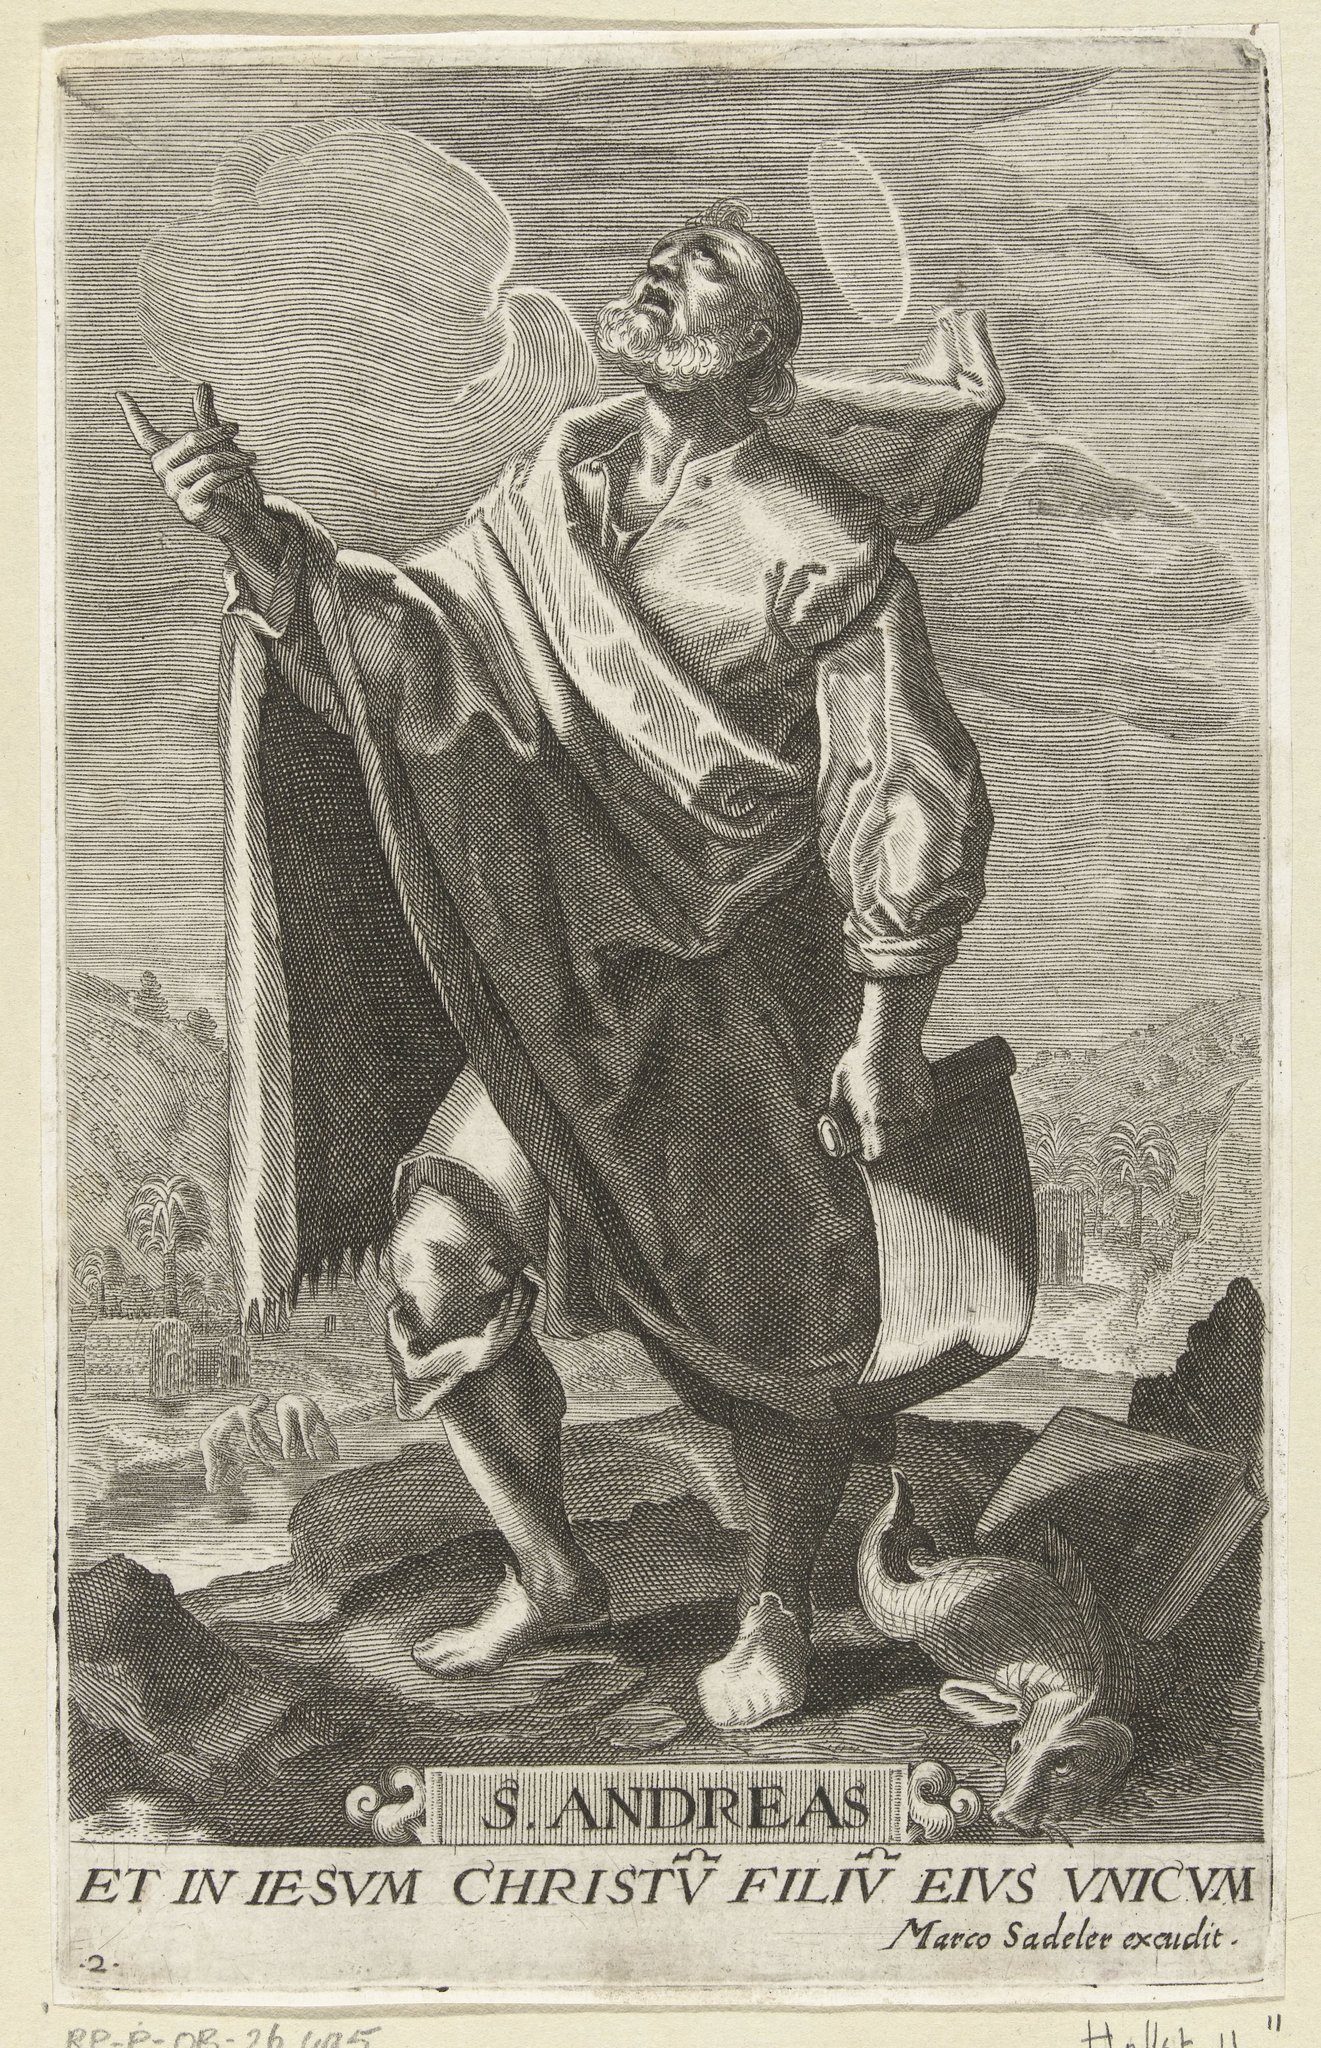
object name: print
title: Christus en twaalf apostelen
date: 1591-1629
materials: paper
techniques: engraving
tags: the apostle andrew; possible attributes: book, x-shaped cross, fish, fishing-net, rope, scroll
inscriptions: collector's mark: Lugt 240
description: Prent naar ontwerp van Joos van Winghe. Prent maakt deel uit van serie met dertien prenten en titelprent van Christus en twaalf apostelen.